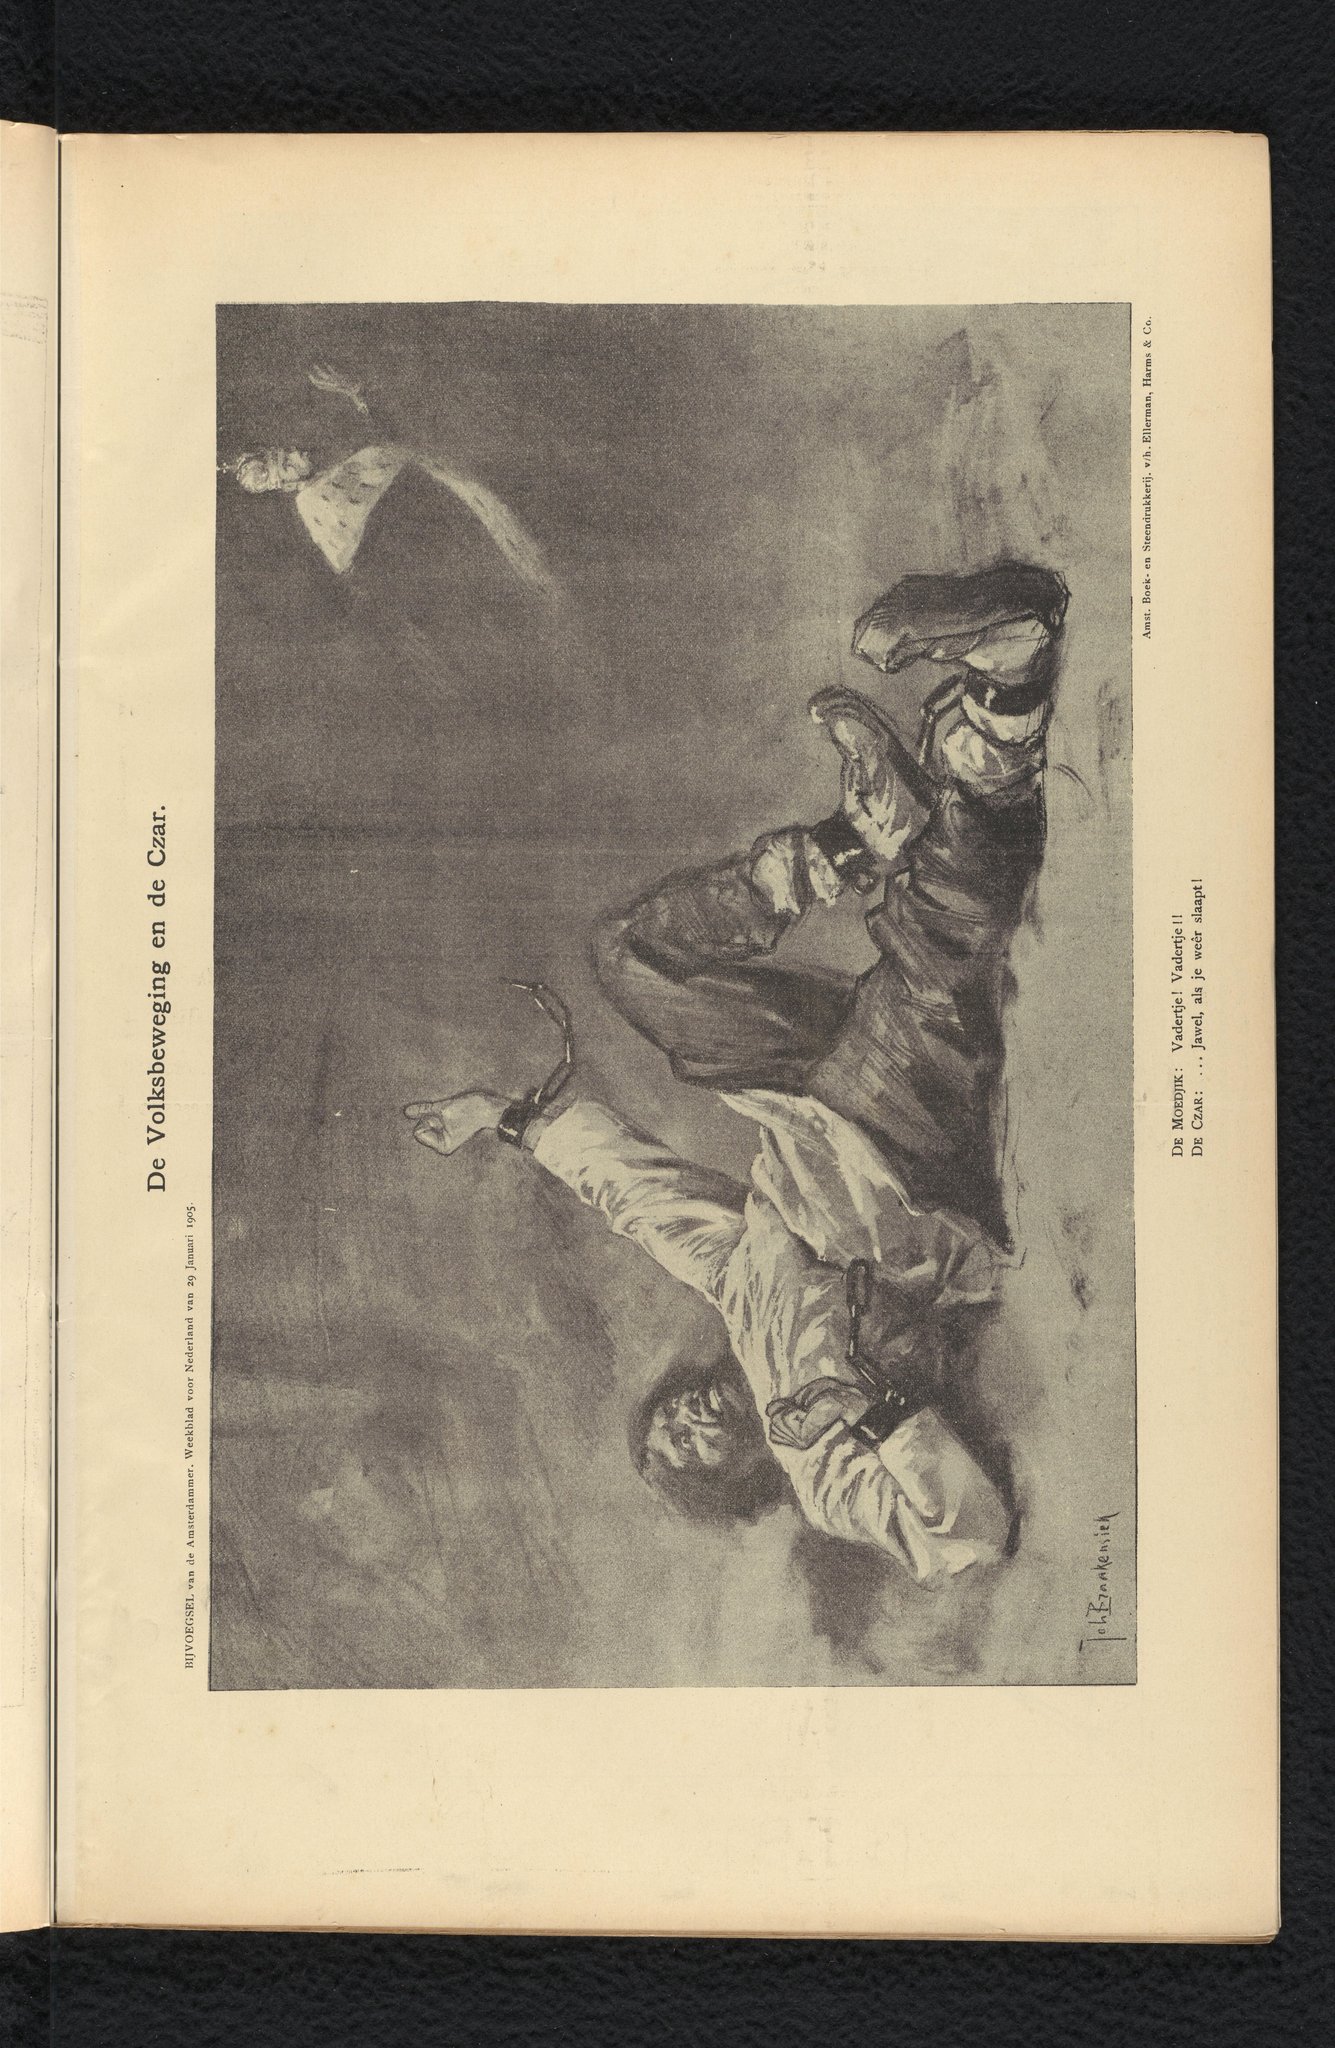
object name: cartoon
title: De Volksbeweging en de Czar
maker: johan braakensiek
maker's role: draughtsman, print maker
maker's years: 1858-1940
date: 1905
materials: paper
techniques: autotype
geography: amsterdam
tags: (person) in fetters, not imprisoned, giants, colossi, political caricatures and satires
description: Een woeste reus, het Russische volk, ontwaakt en verbreekt zijn ketens, op de achtergrond vlucht de Russische tsaar Nicolaas II weg. Naar aanleiding van het uitbreken van de Revolutie van 1905 op 22 januari.